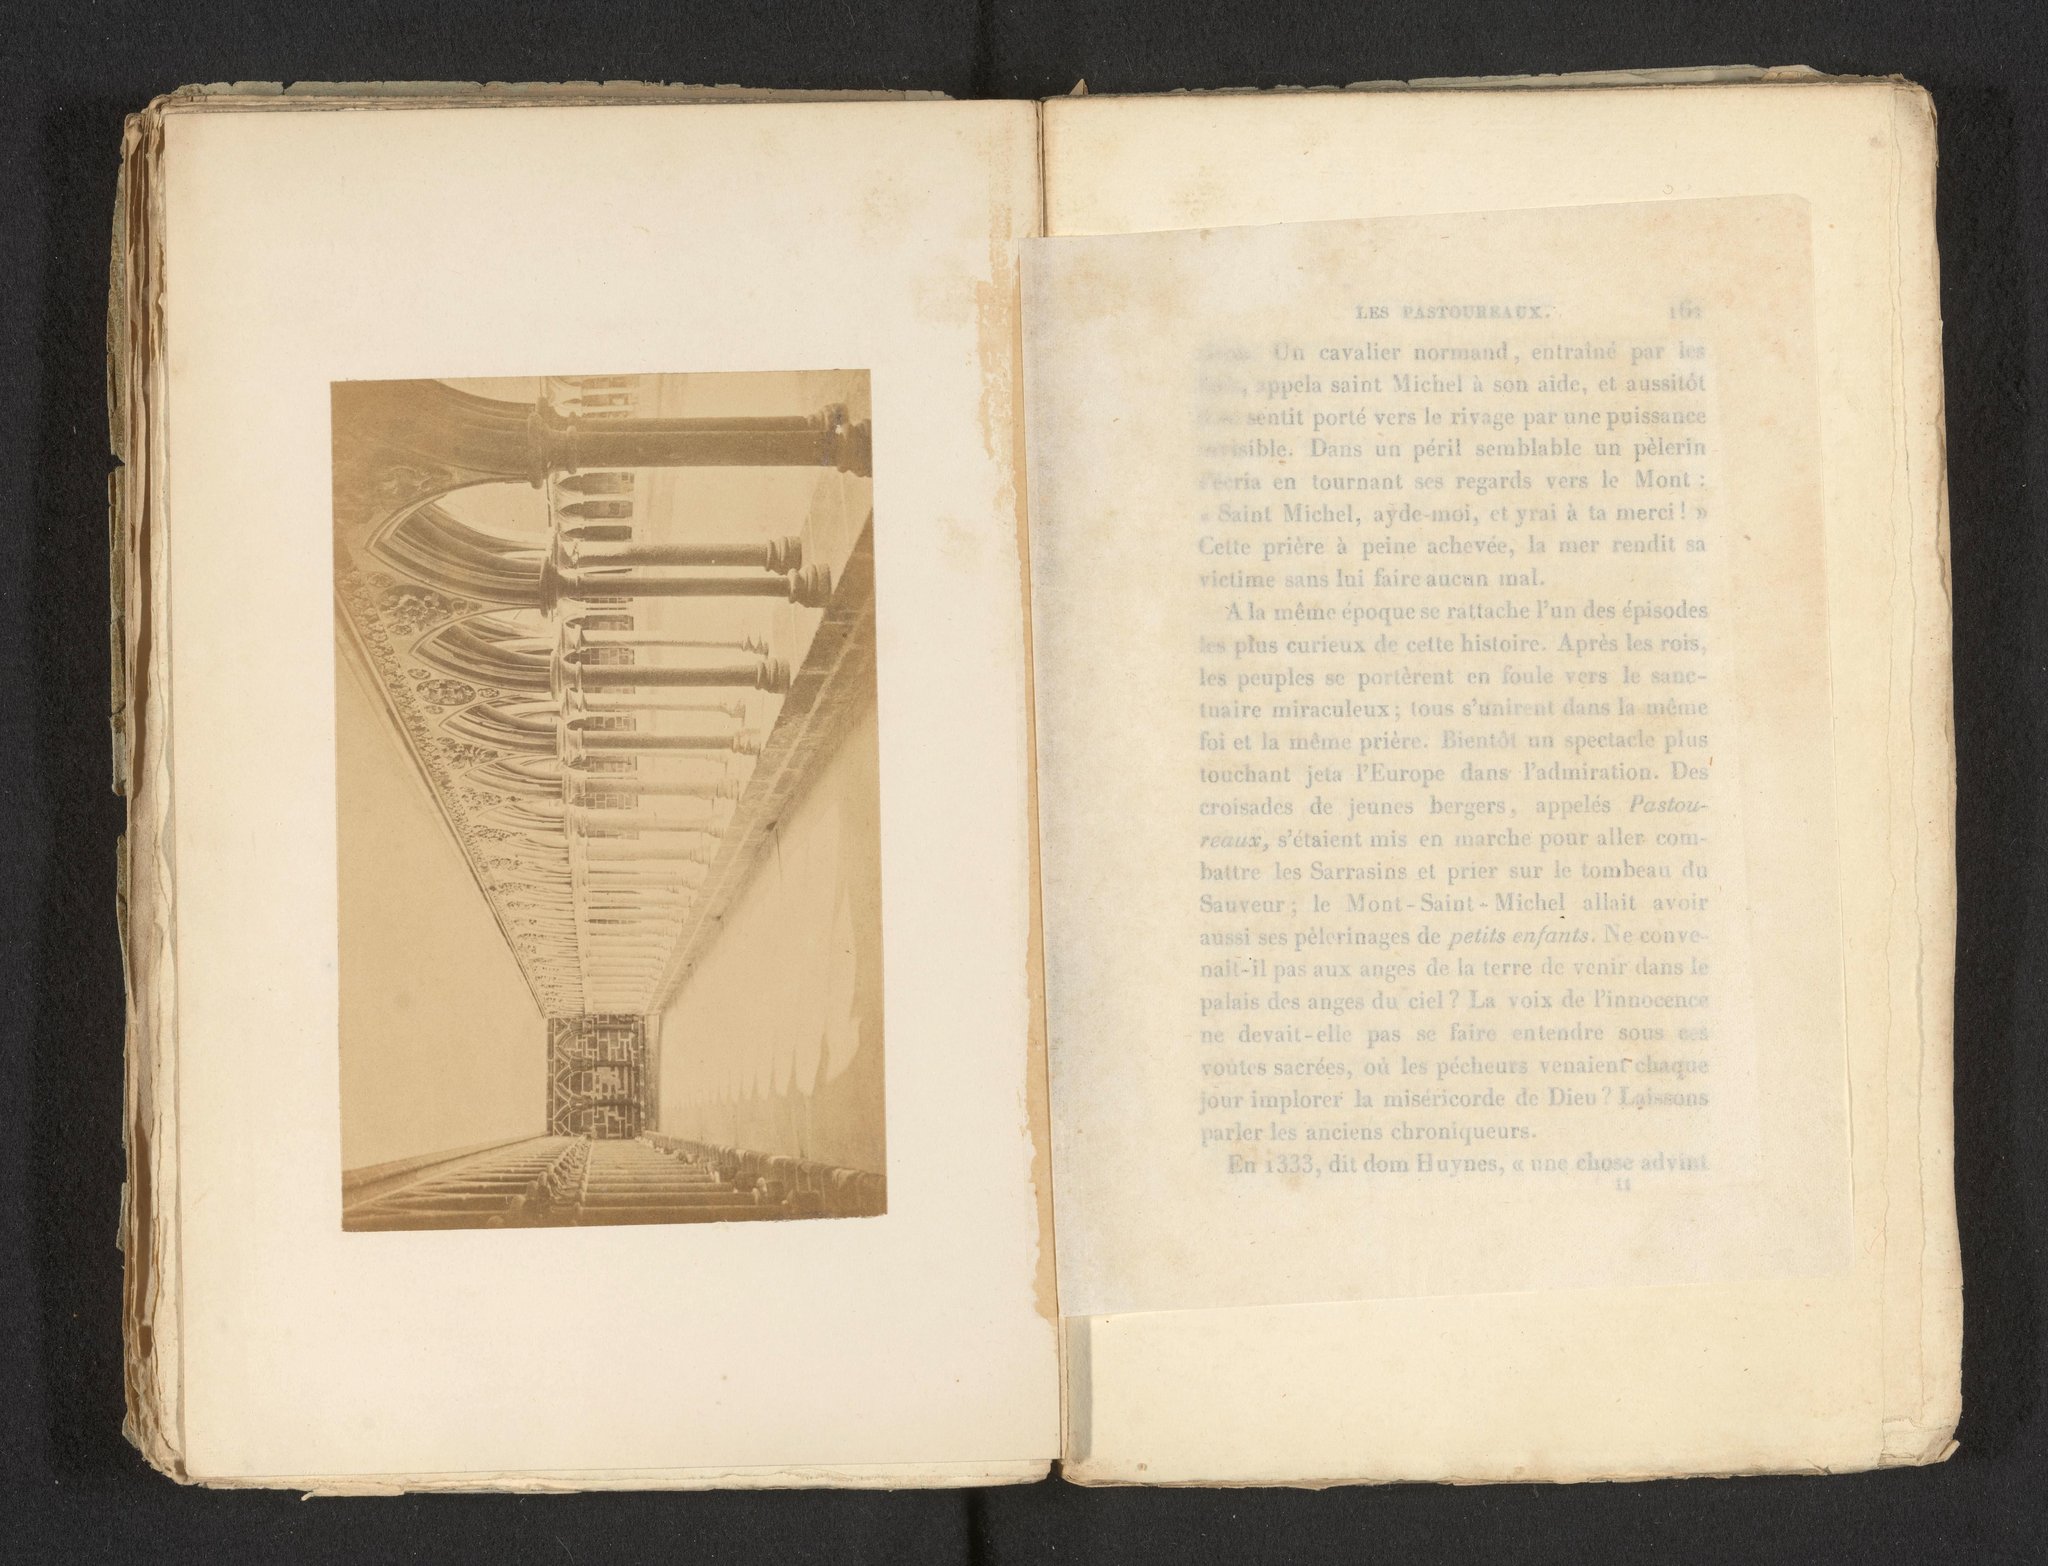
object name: photograph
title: Kloostergang in het klooster van Mont Saint-Michel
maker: Anonymous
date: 1866-1876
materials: photographic support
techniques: albumen print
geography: mont saint-michel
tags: cloisters ~ monastery